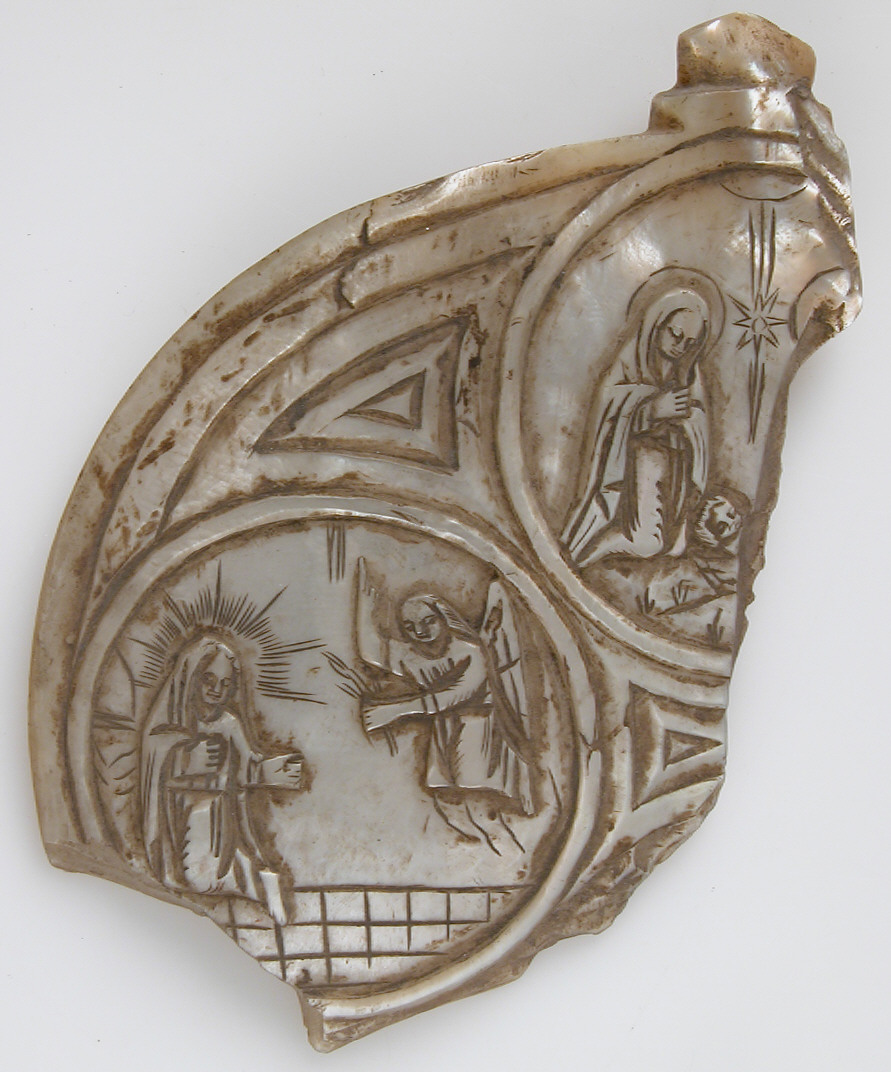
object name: shell fragment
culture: german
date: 1501-1600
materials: mother of pearl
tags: women